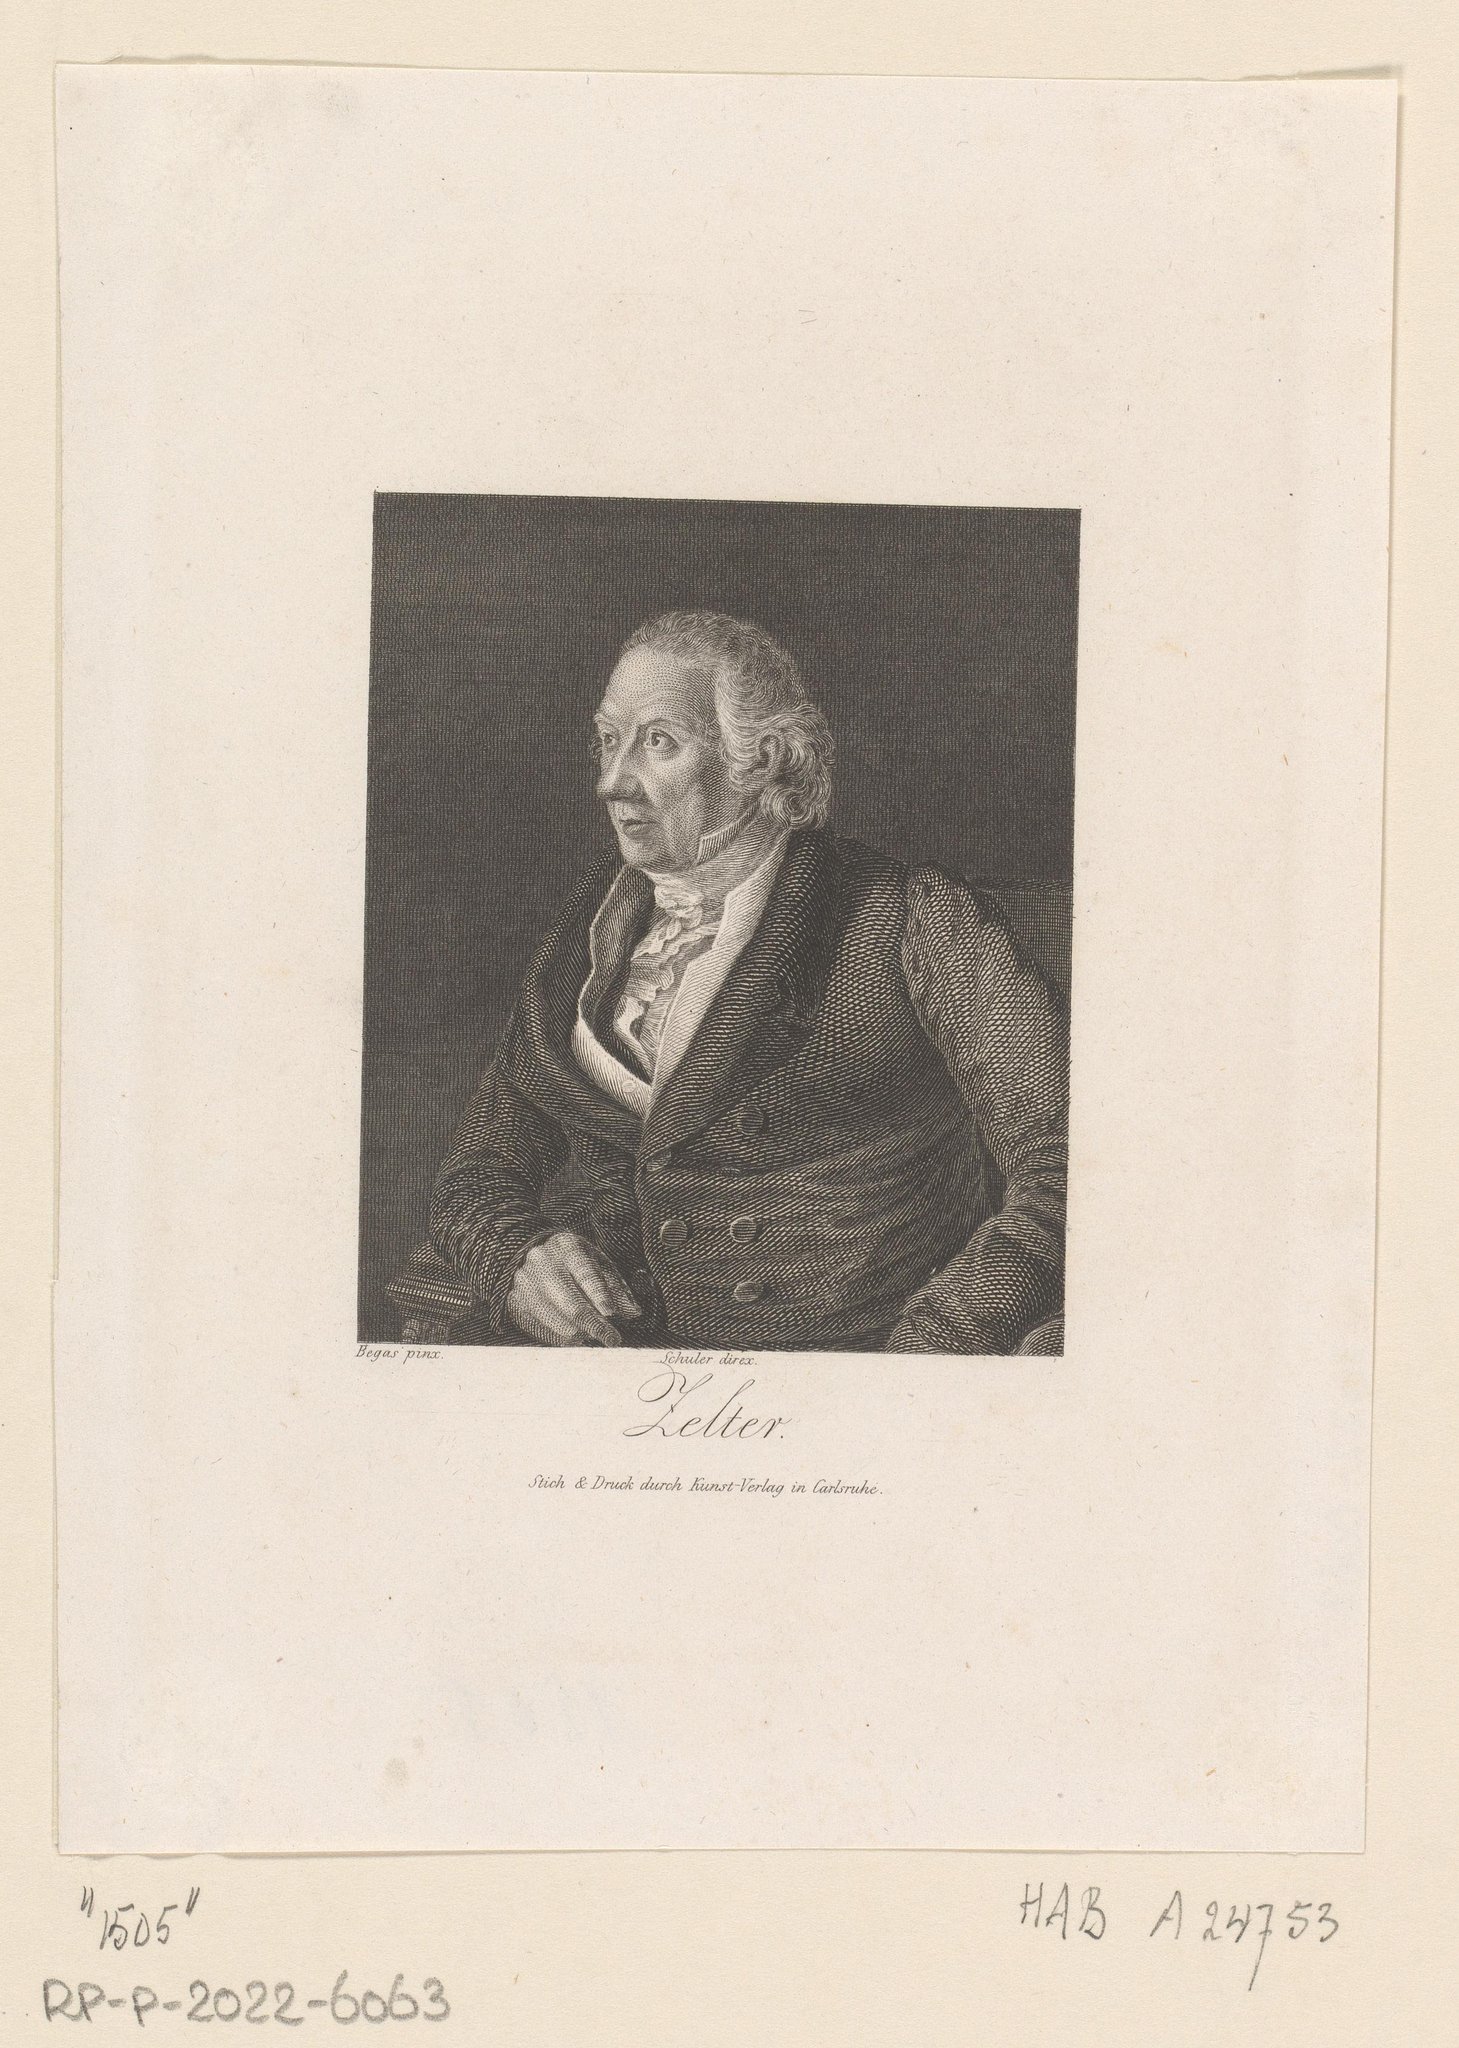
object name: print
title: Portret van Carl Friedrich Zelter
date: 1834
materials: paper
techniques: engraving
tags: berlin, musician, historical persons, portrait of composer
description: Prent waarschijnlijk uit: Urania: Taschenbuch. Leipzig: Friedrich Arnold Brockhaus, 1834.